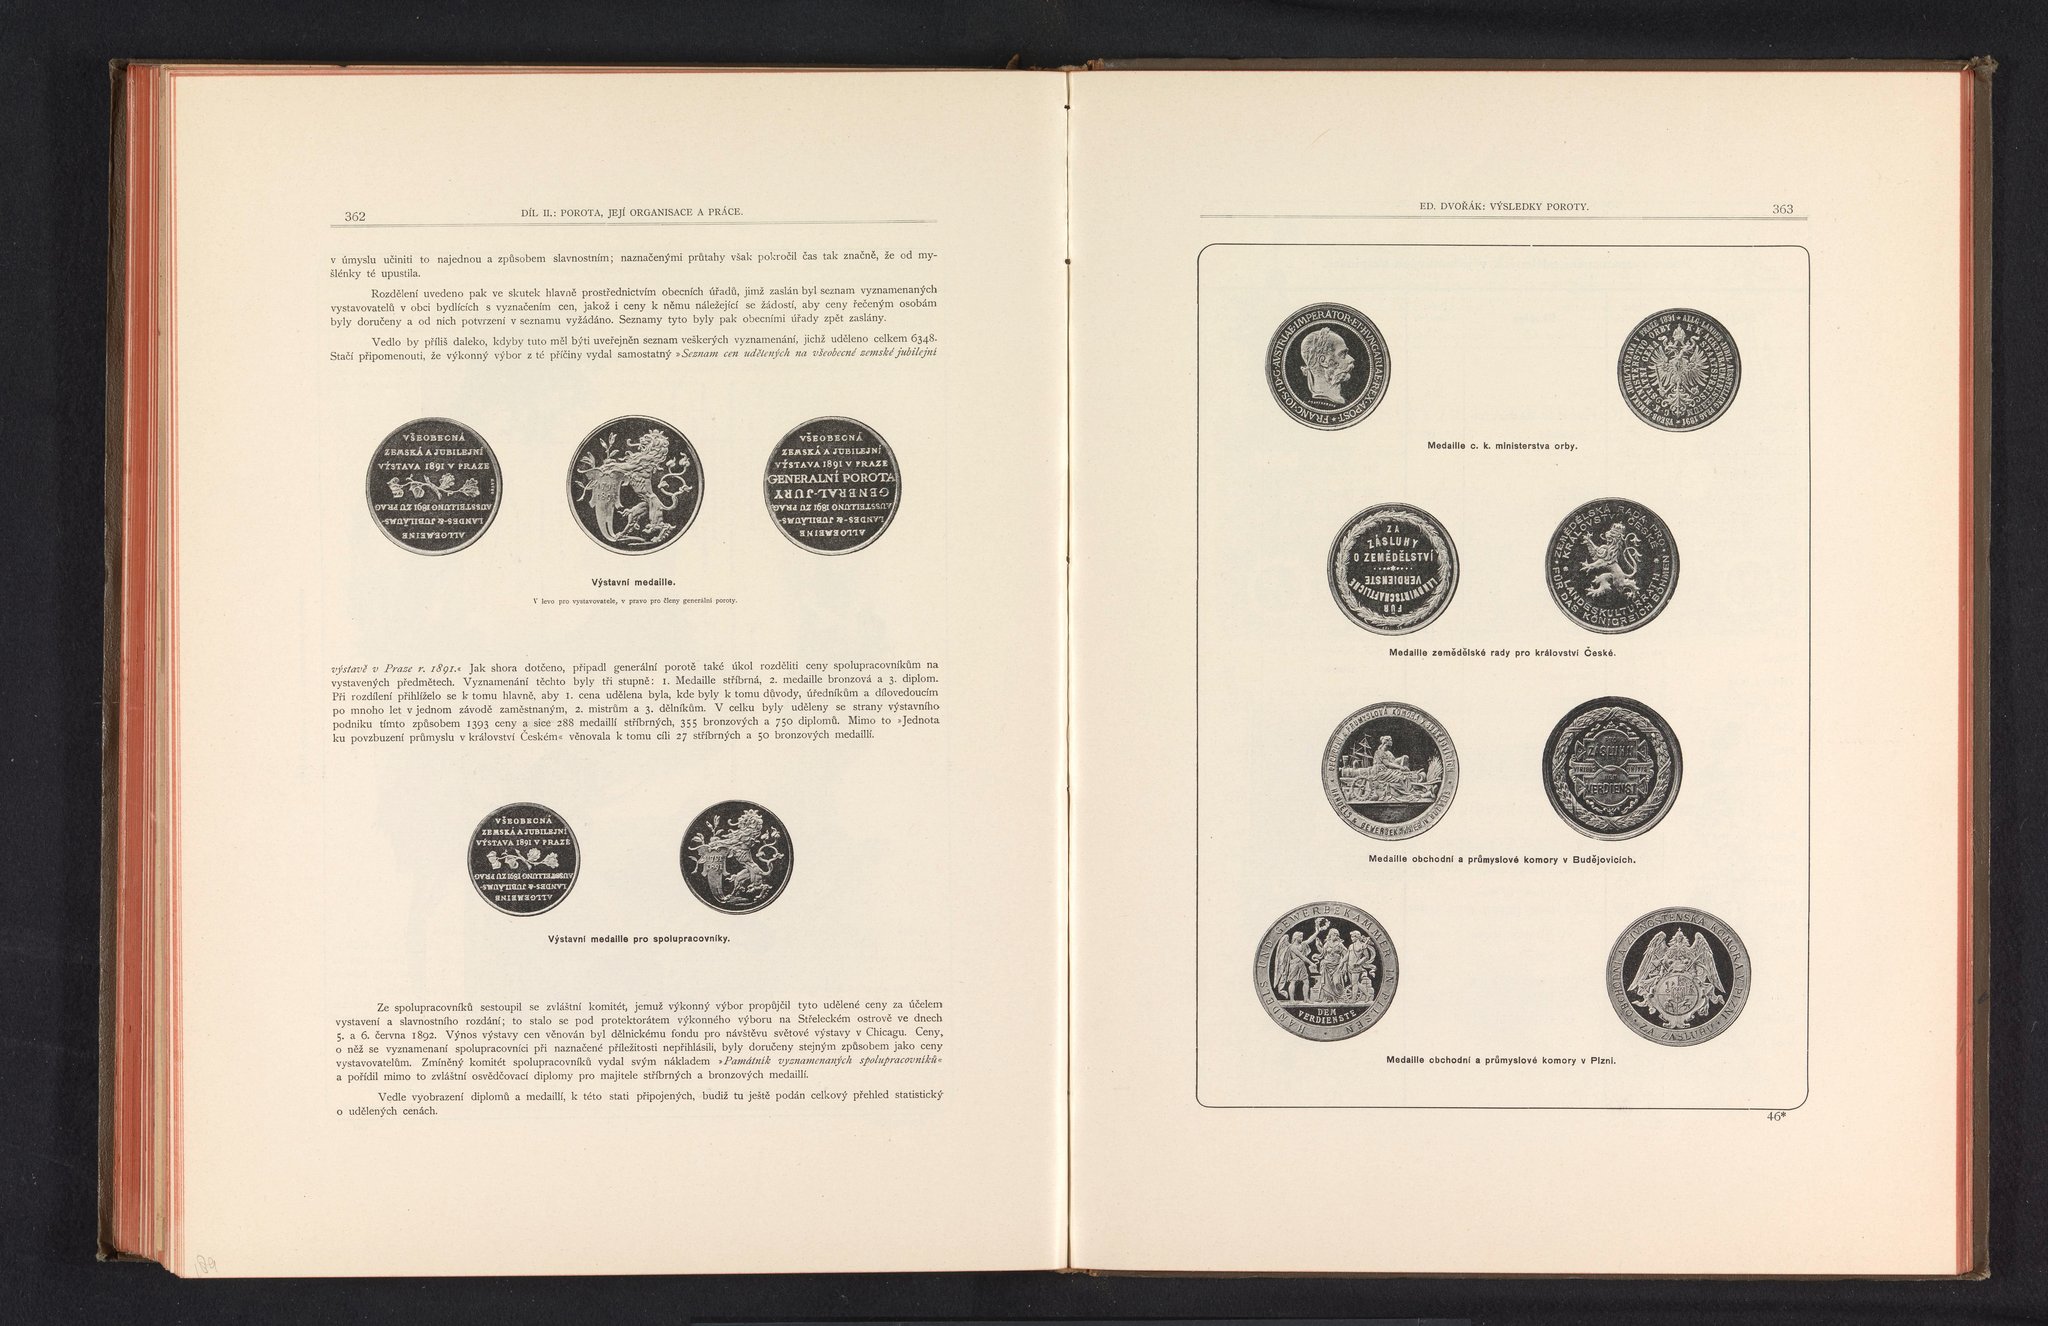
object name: page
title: Výstavny zemedelské rady pro královstvi Ceské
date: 1891-1893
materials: paper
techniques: autotype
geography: prague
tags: memorial medal